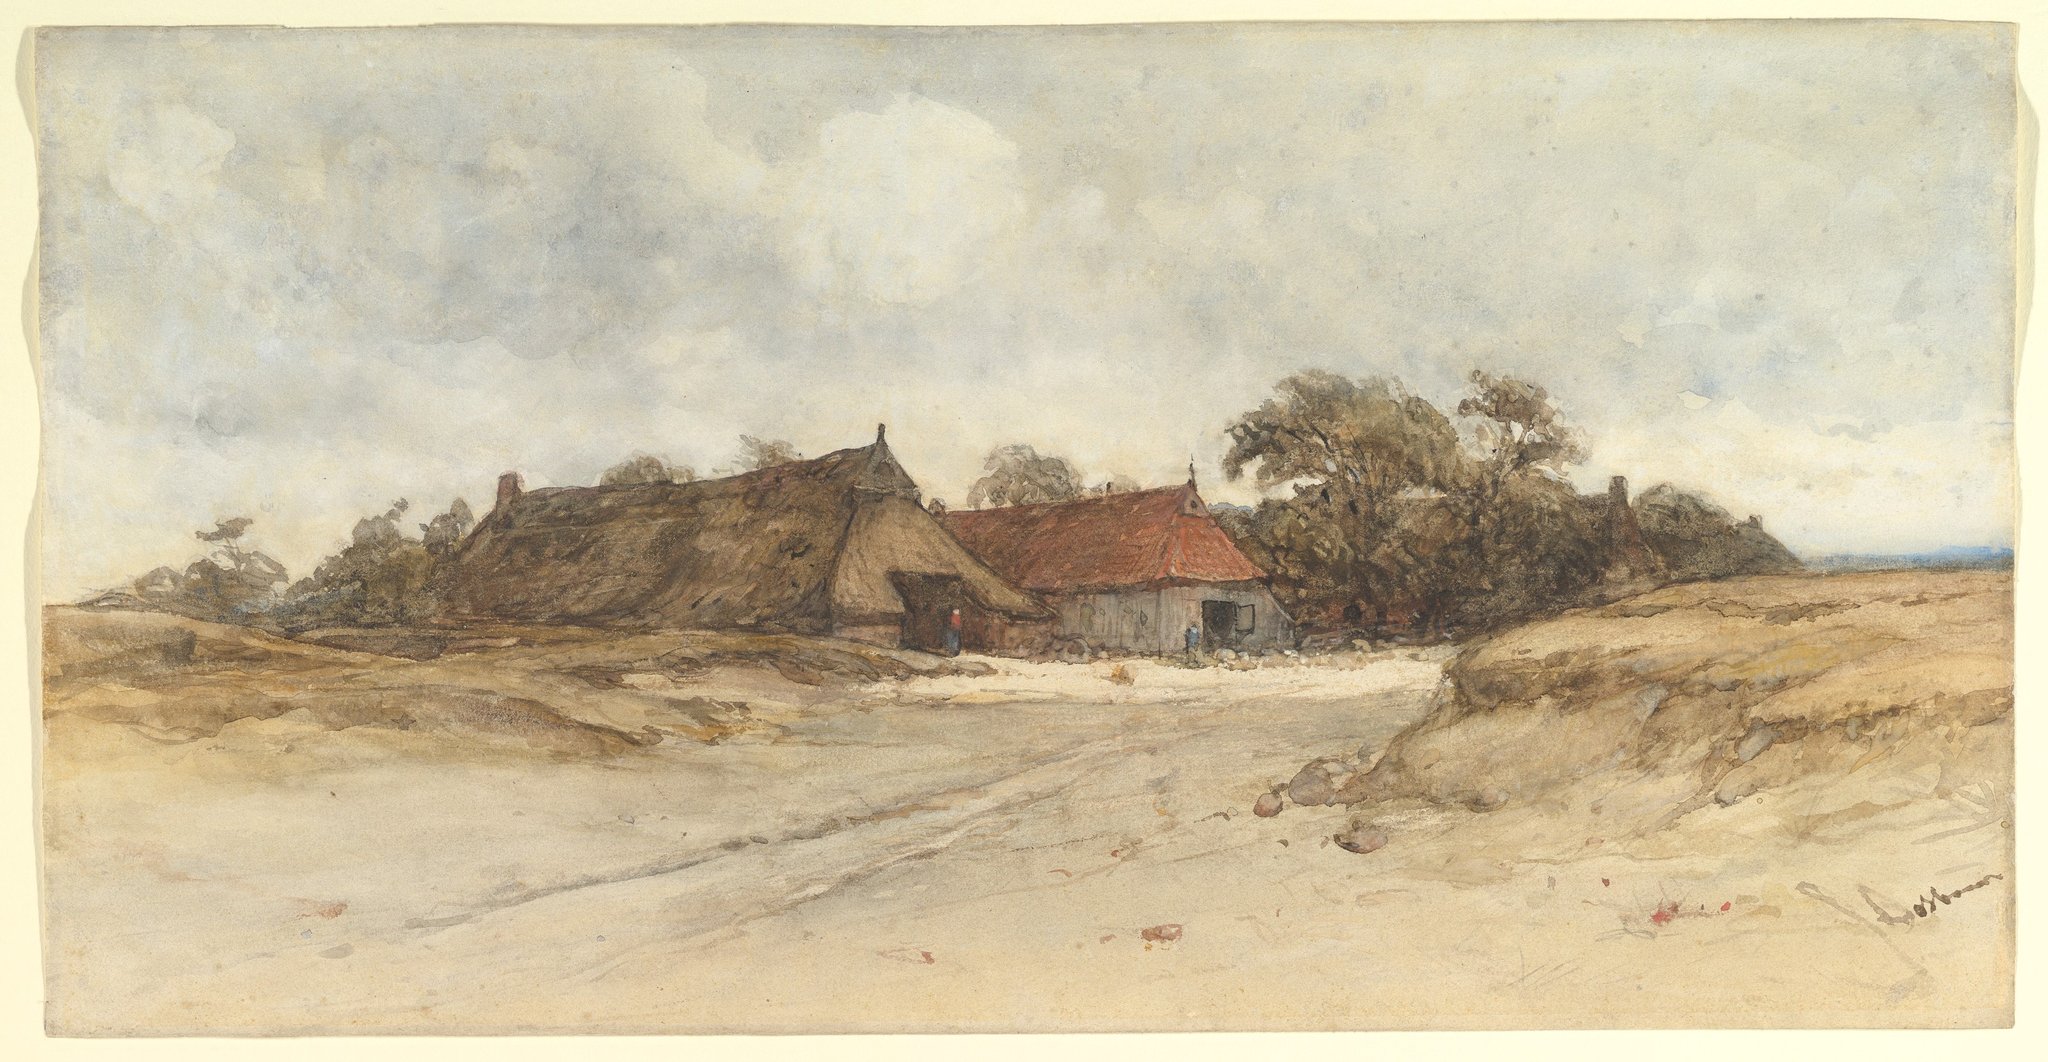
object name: drawing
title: Farmhouses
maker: johannes bosboom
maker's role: artist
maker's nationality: dutch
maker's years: 1817-1891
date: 1801-1900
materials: watercolor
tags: houses,landscapes,trees